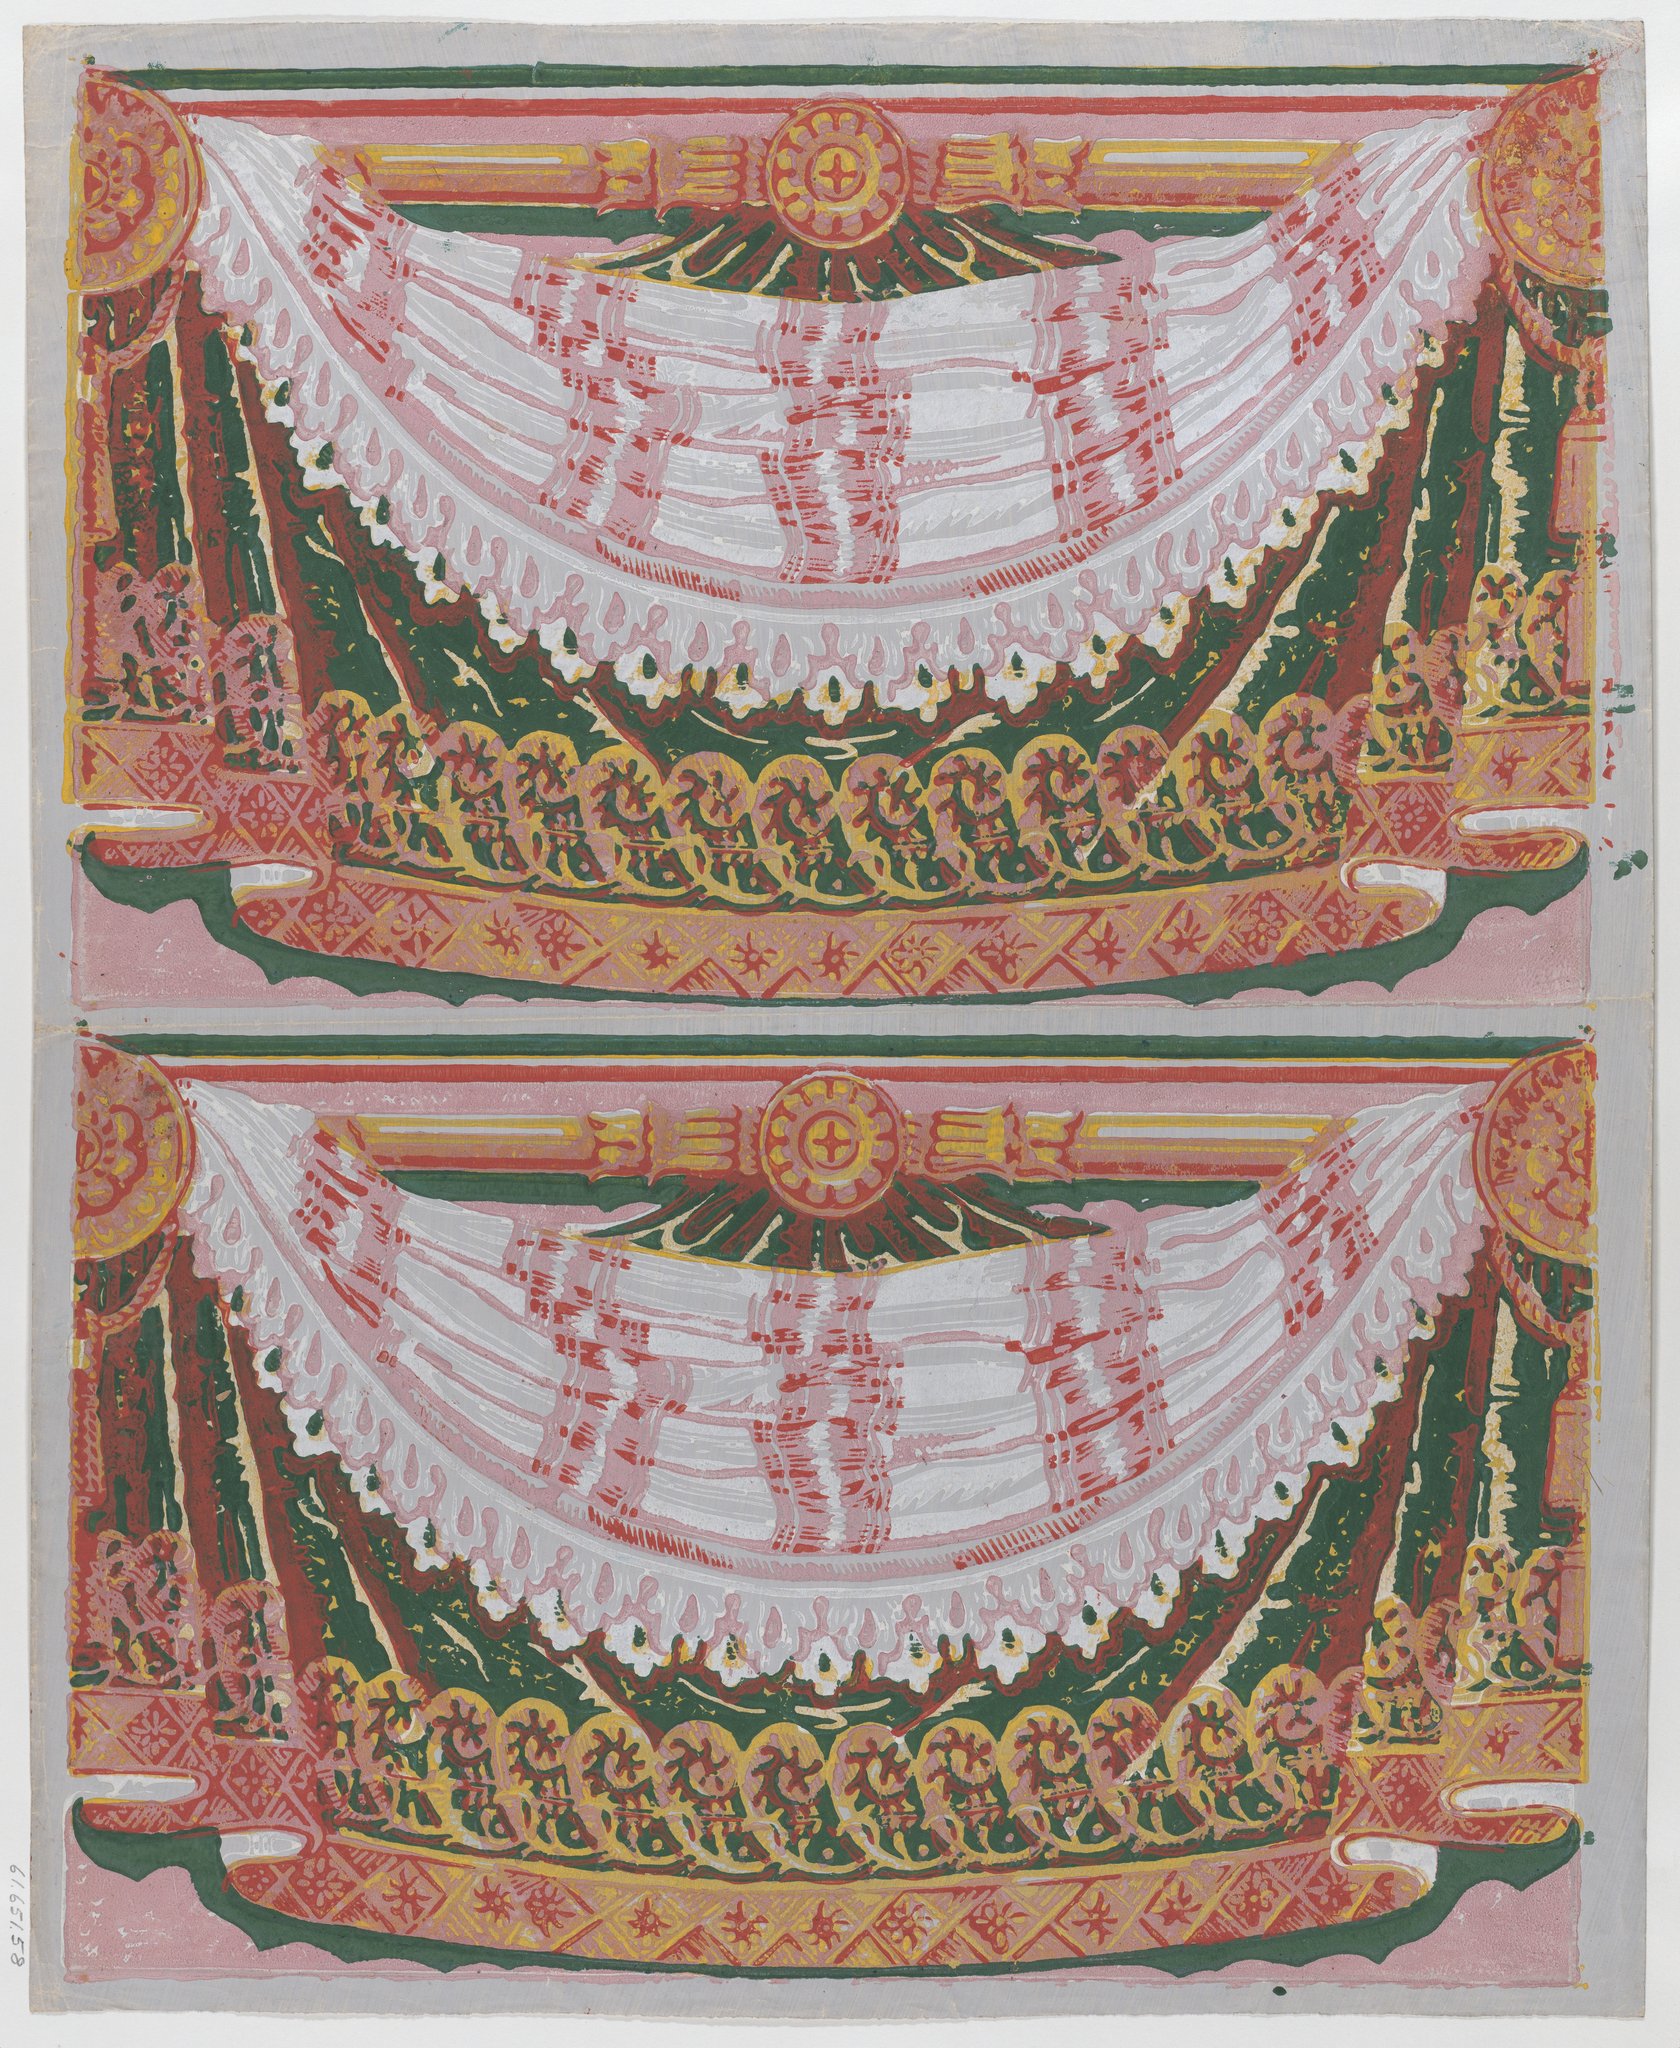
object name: print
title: Sheet with two borders with a curved drapery against a curtain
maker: Anonymous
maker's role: artist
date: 1767-1866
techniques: relief print